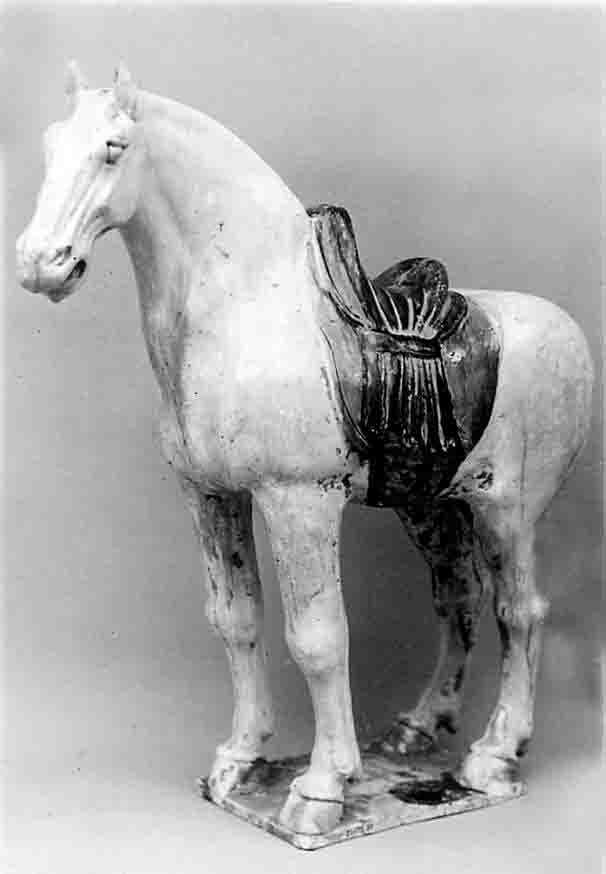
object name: figure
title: Horse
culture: chinese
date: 601-800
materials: earthenware, glaze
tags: horses